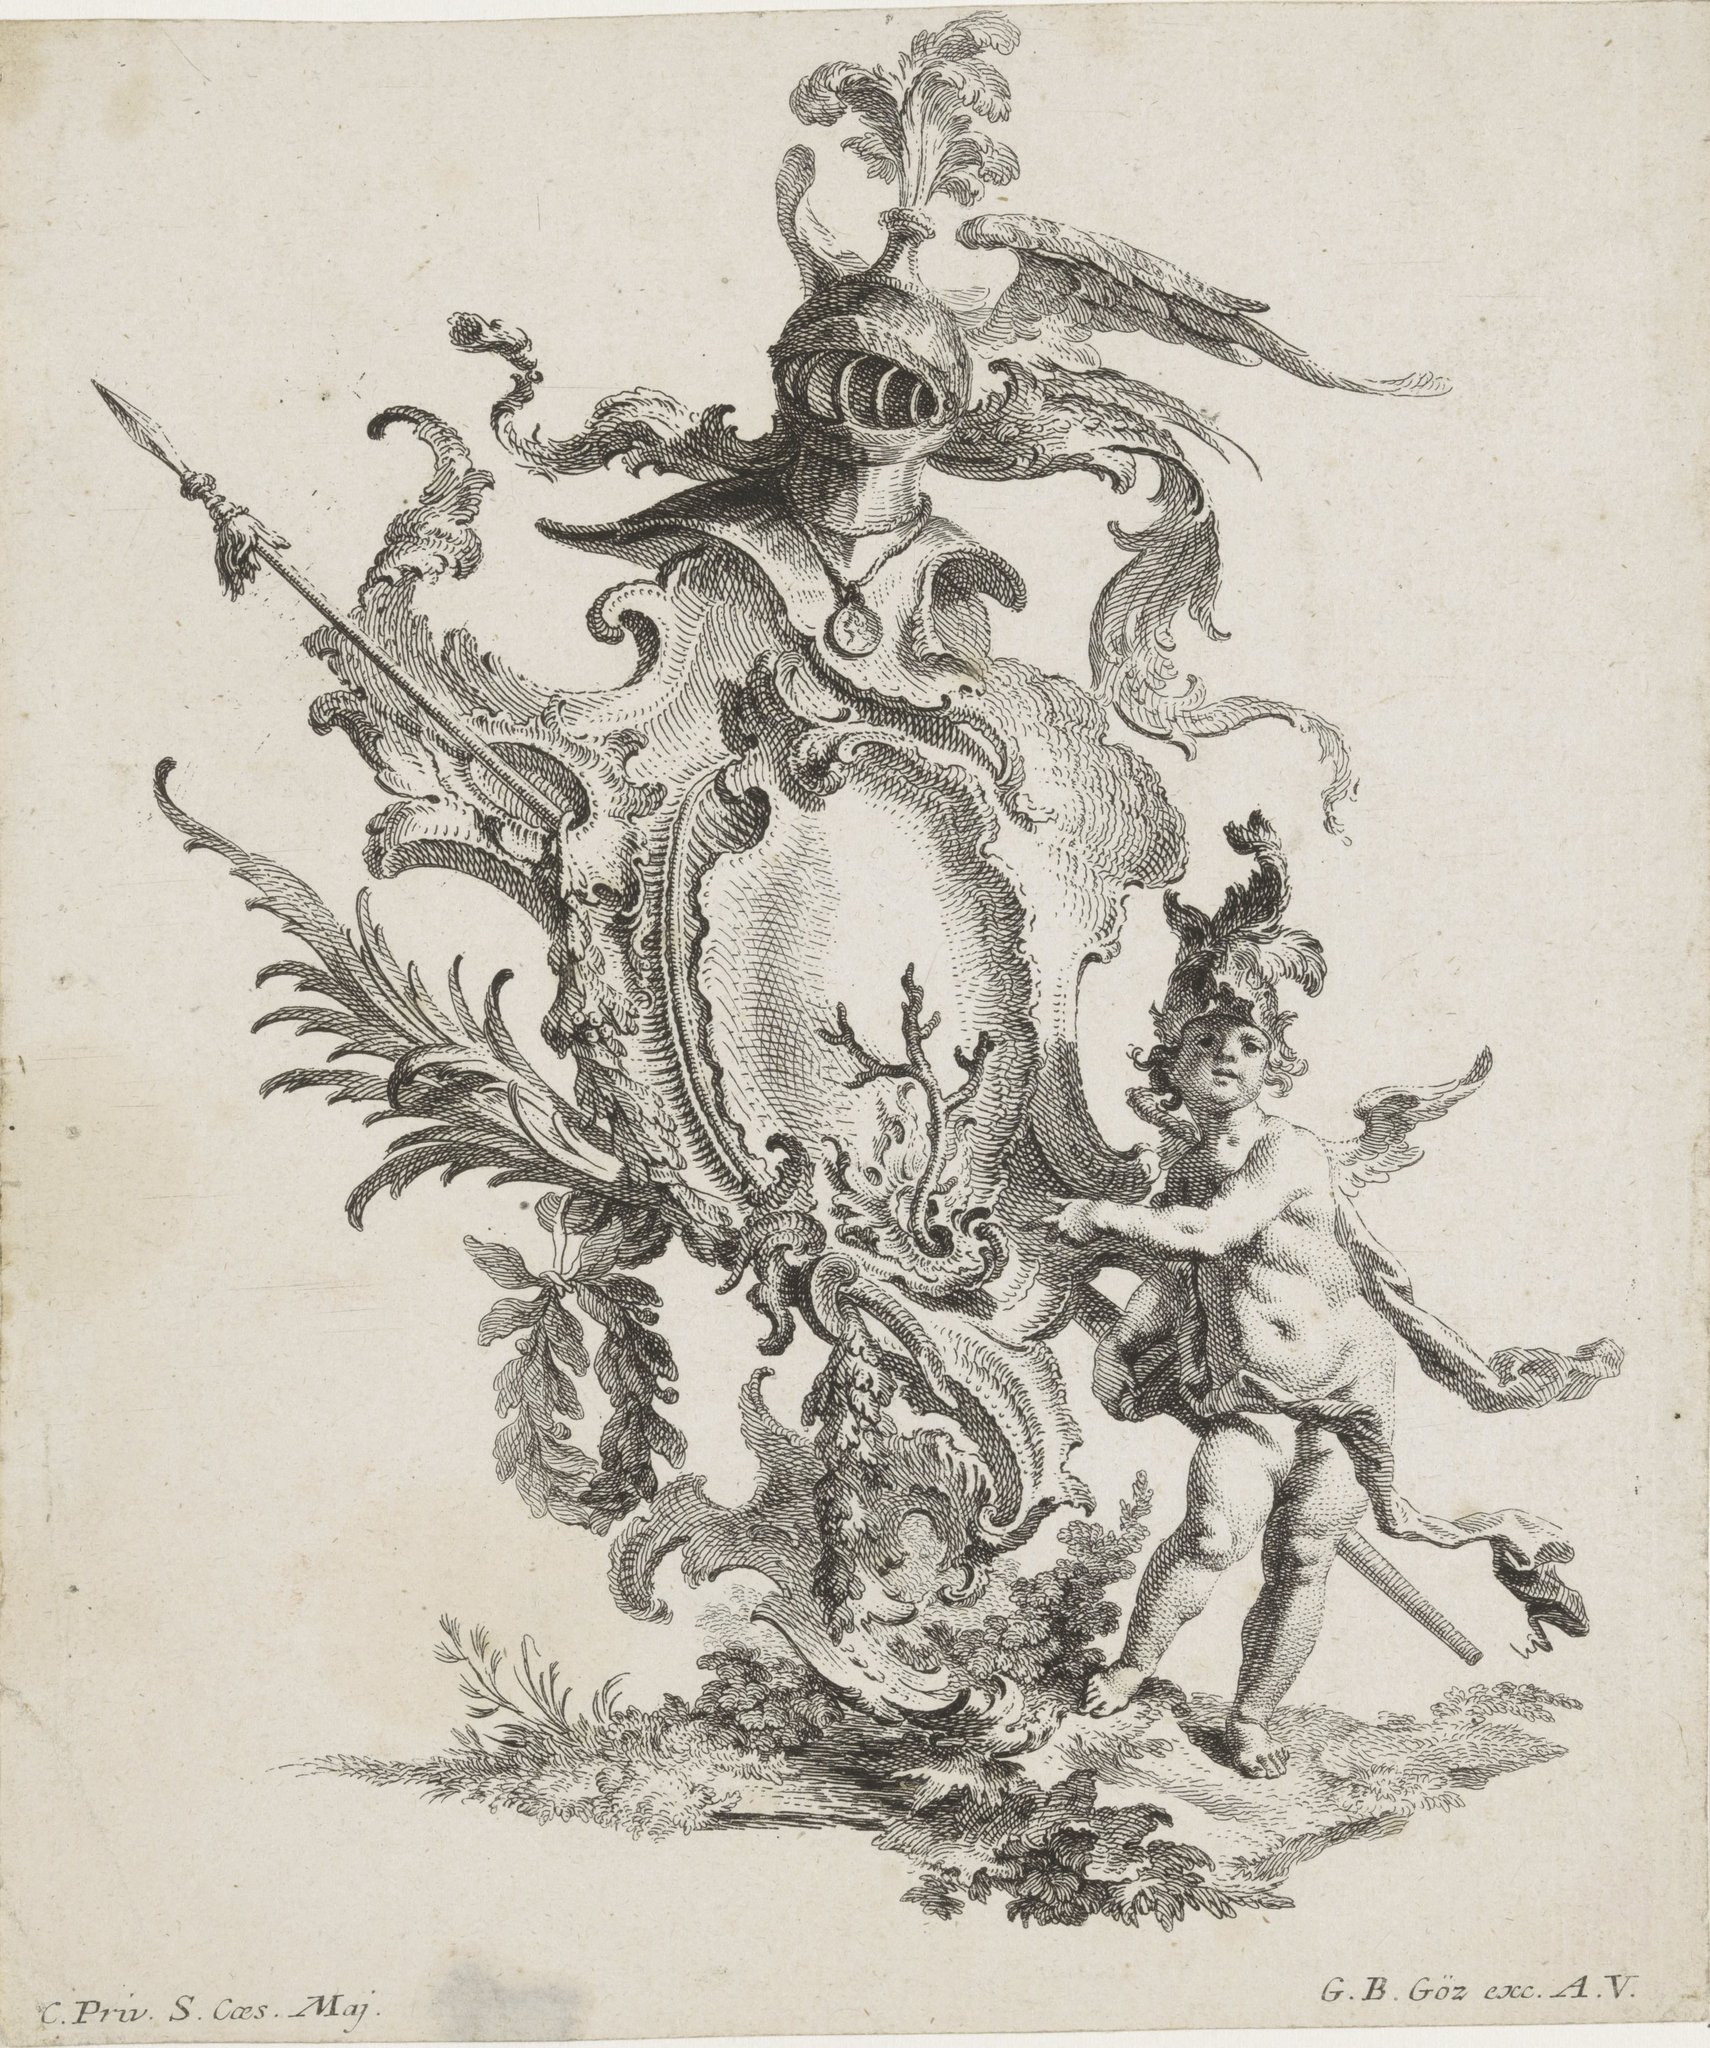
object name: print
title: Rocaille cartouche met helm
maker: gottfried bernhard götz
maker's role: artist, draughtsman, painter, print maker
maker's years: 1708-1774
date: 1718-1774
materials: paper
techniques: etching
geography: augsburg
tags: helmet, rocaille ornament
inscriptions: collector's mark: Lugt 2228, collector's mark: Lugt 2760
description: Rocaille cartouche, bekroond met helm. Putto met helm en speer rechts.